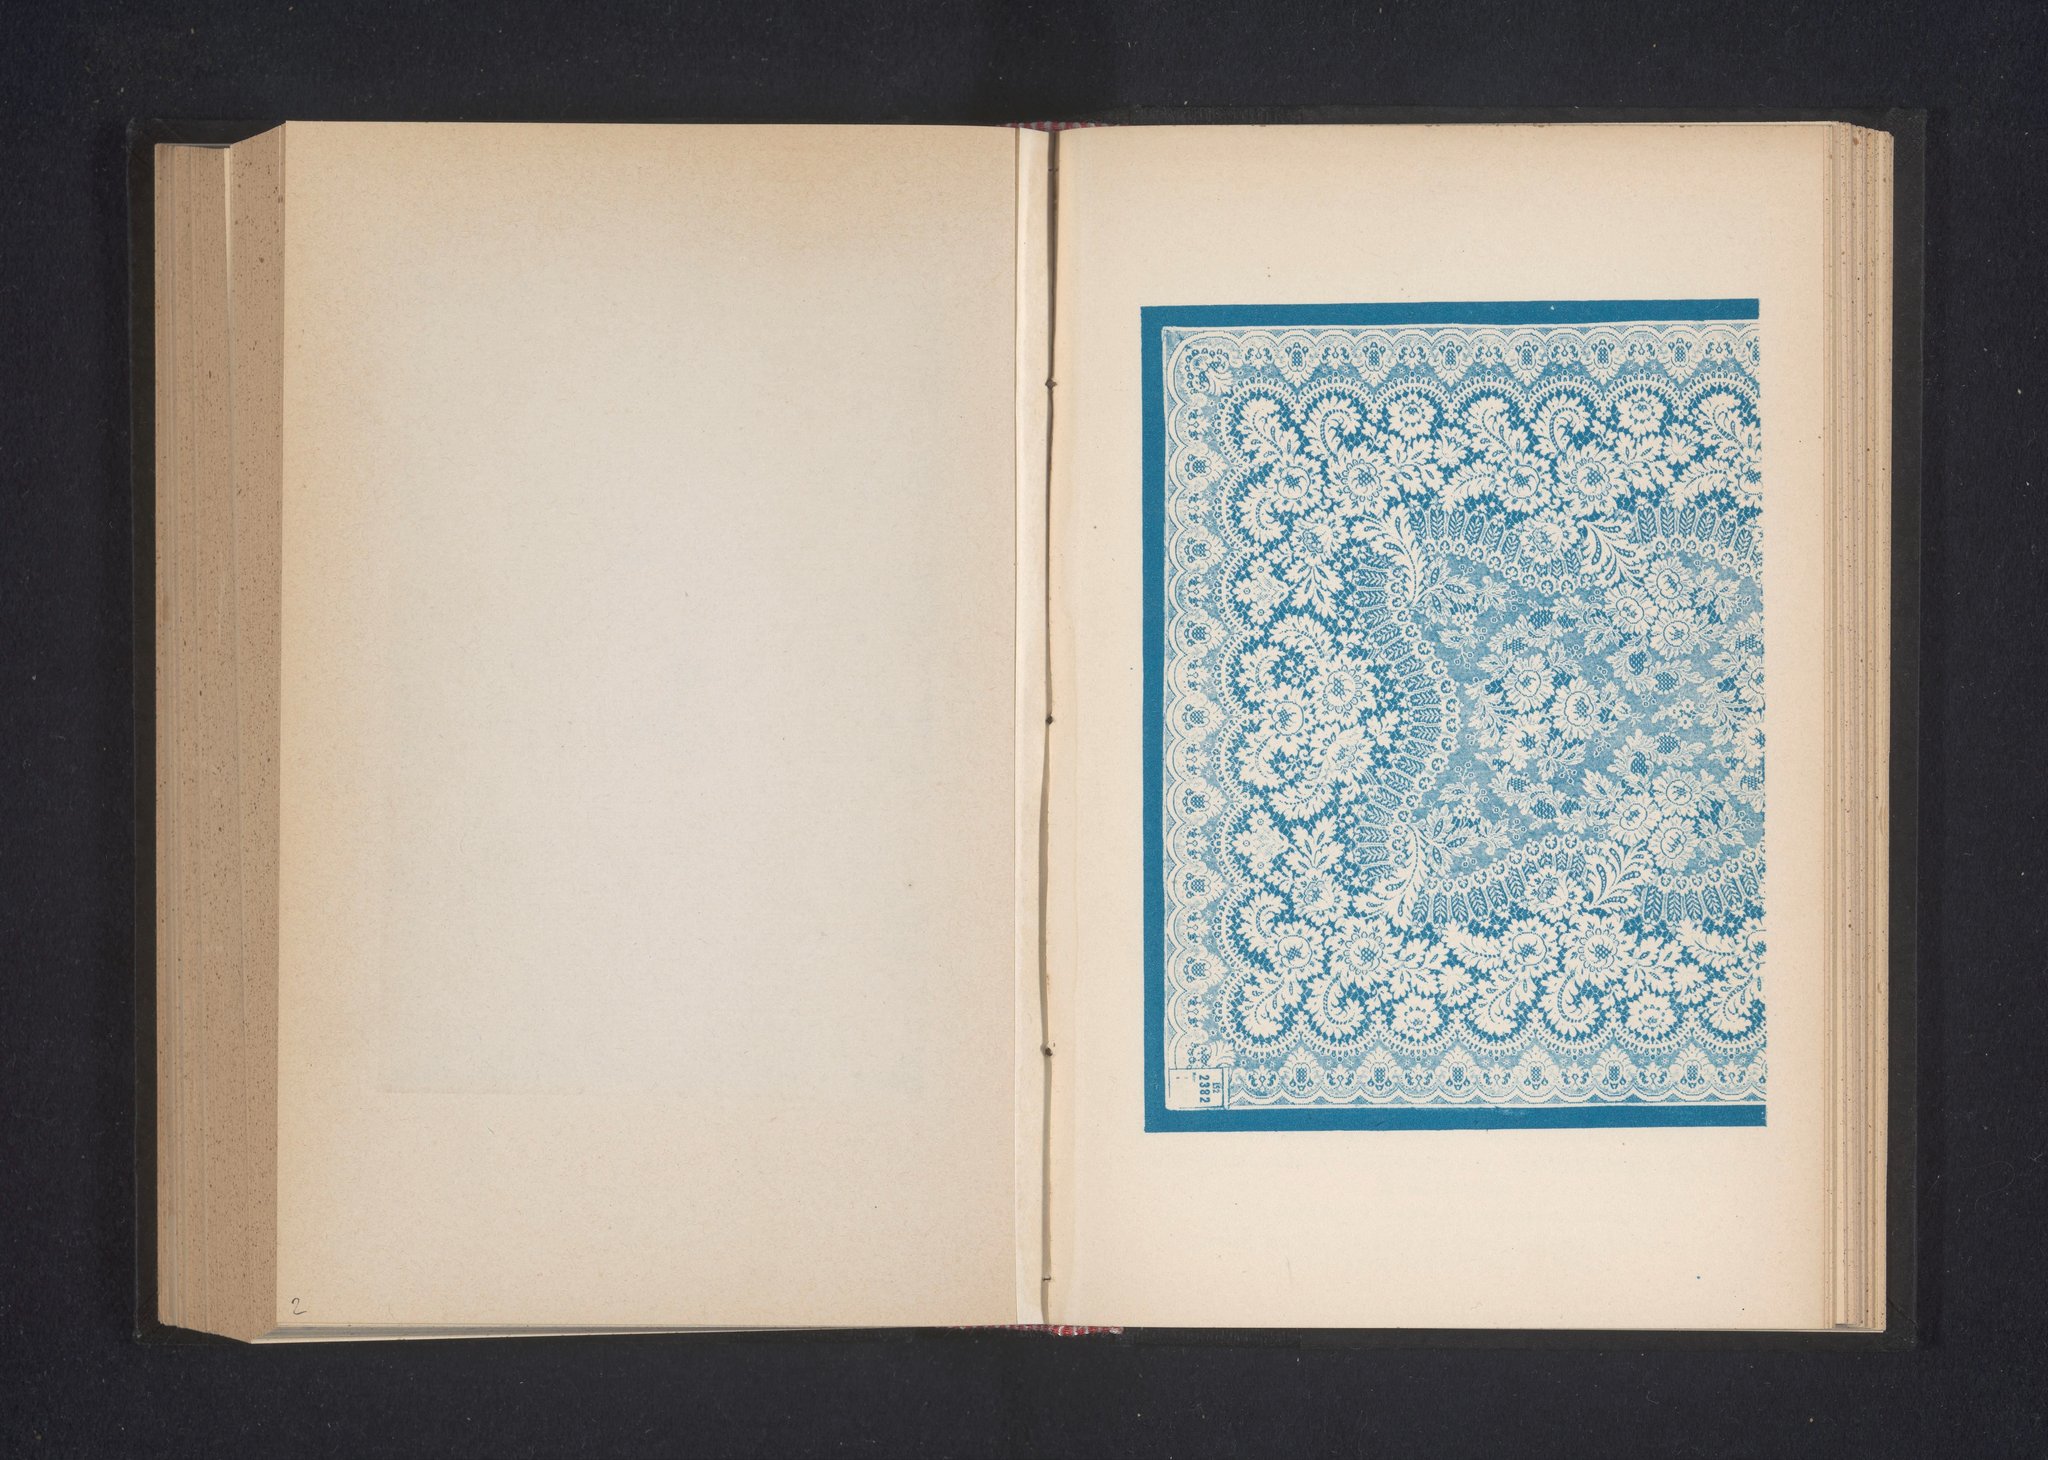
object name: photomechanical print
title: Gedecoreerd kleed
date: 1885-1890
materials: paper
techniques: photolithography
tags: carpet, rug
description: Prent op zevende ongenummerde pagina na pagina 400.